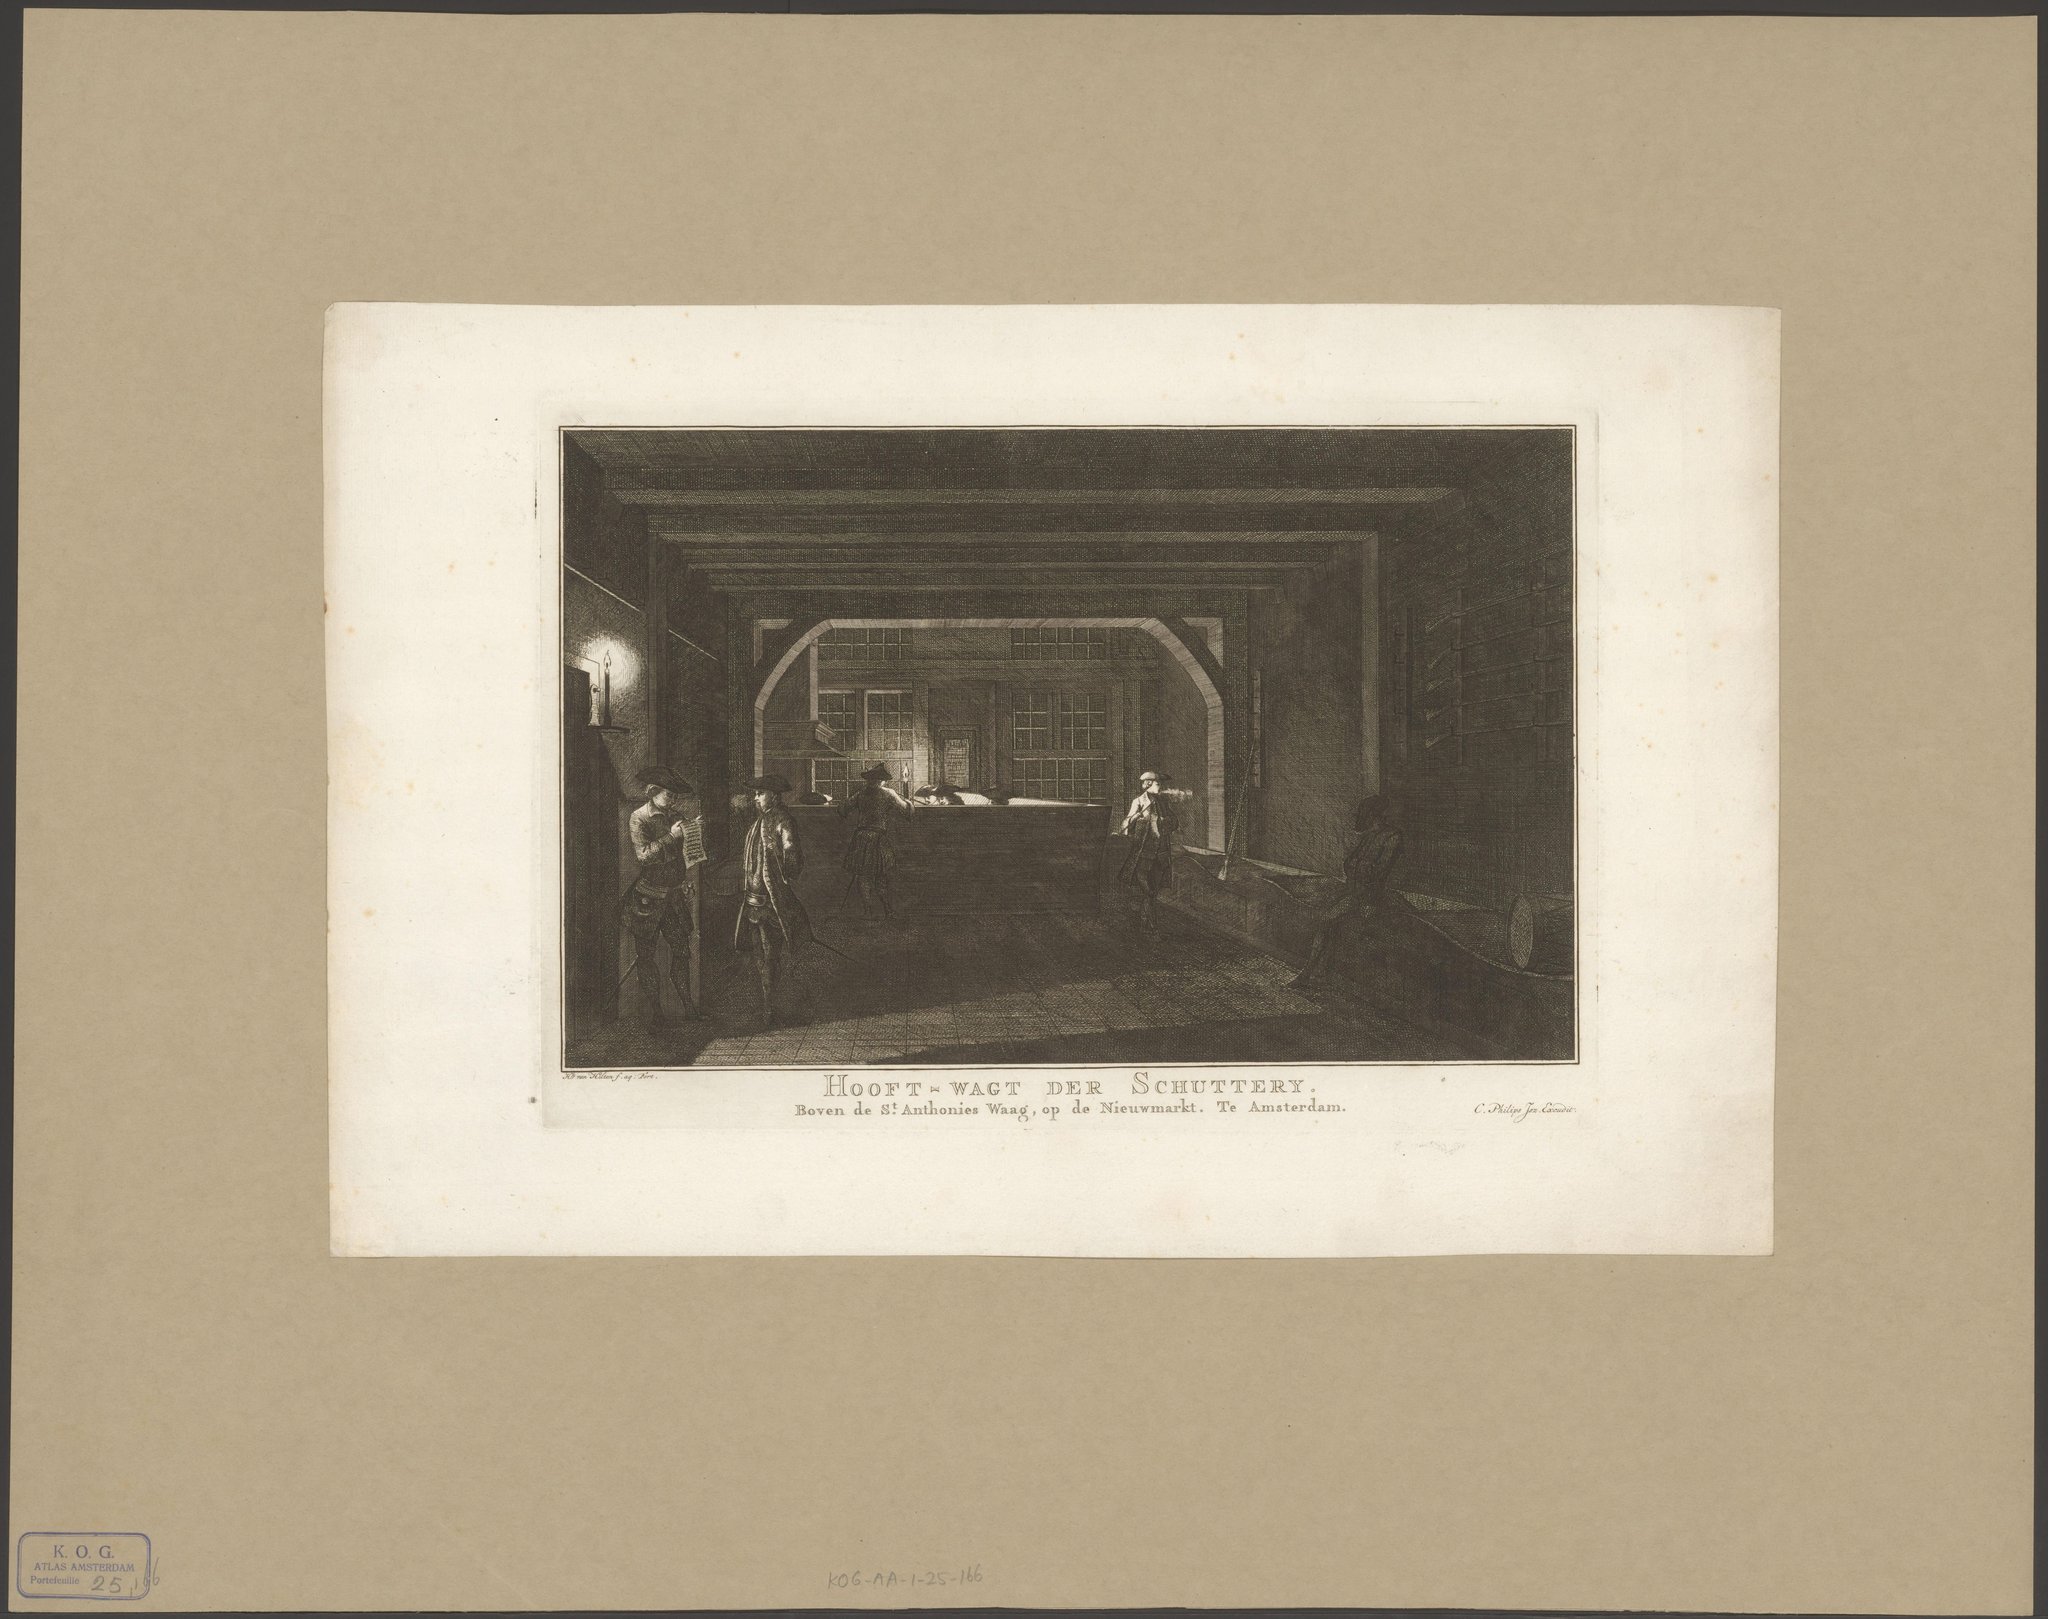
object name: print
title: Hooft-wagt der Schuttery. Boven de St. Anthonieswaag, op de Nieuwmarkt. Te Amsterdam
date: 1750-1793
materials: paper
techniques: etching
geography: amsterdam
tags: pipe ~ tobacco, guard duty, keeping sentry, night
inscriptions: collector's mark: ‘25.166’ Lugt 1641b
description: Onderwerpsrubriek binnen de Atlas Amsterdam: Krijgswezen I: De Admiraliteit van Amsterdam, E. Doelen en Wachthuizen.